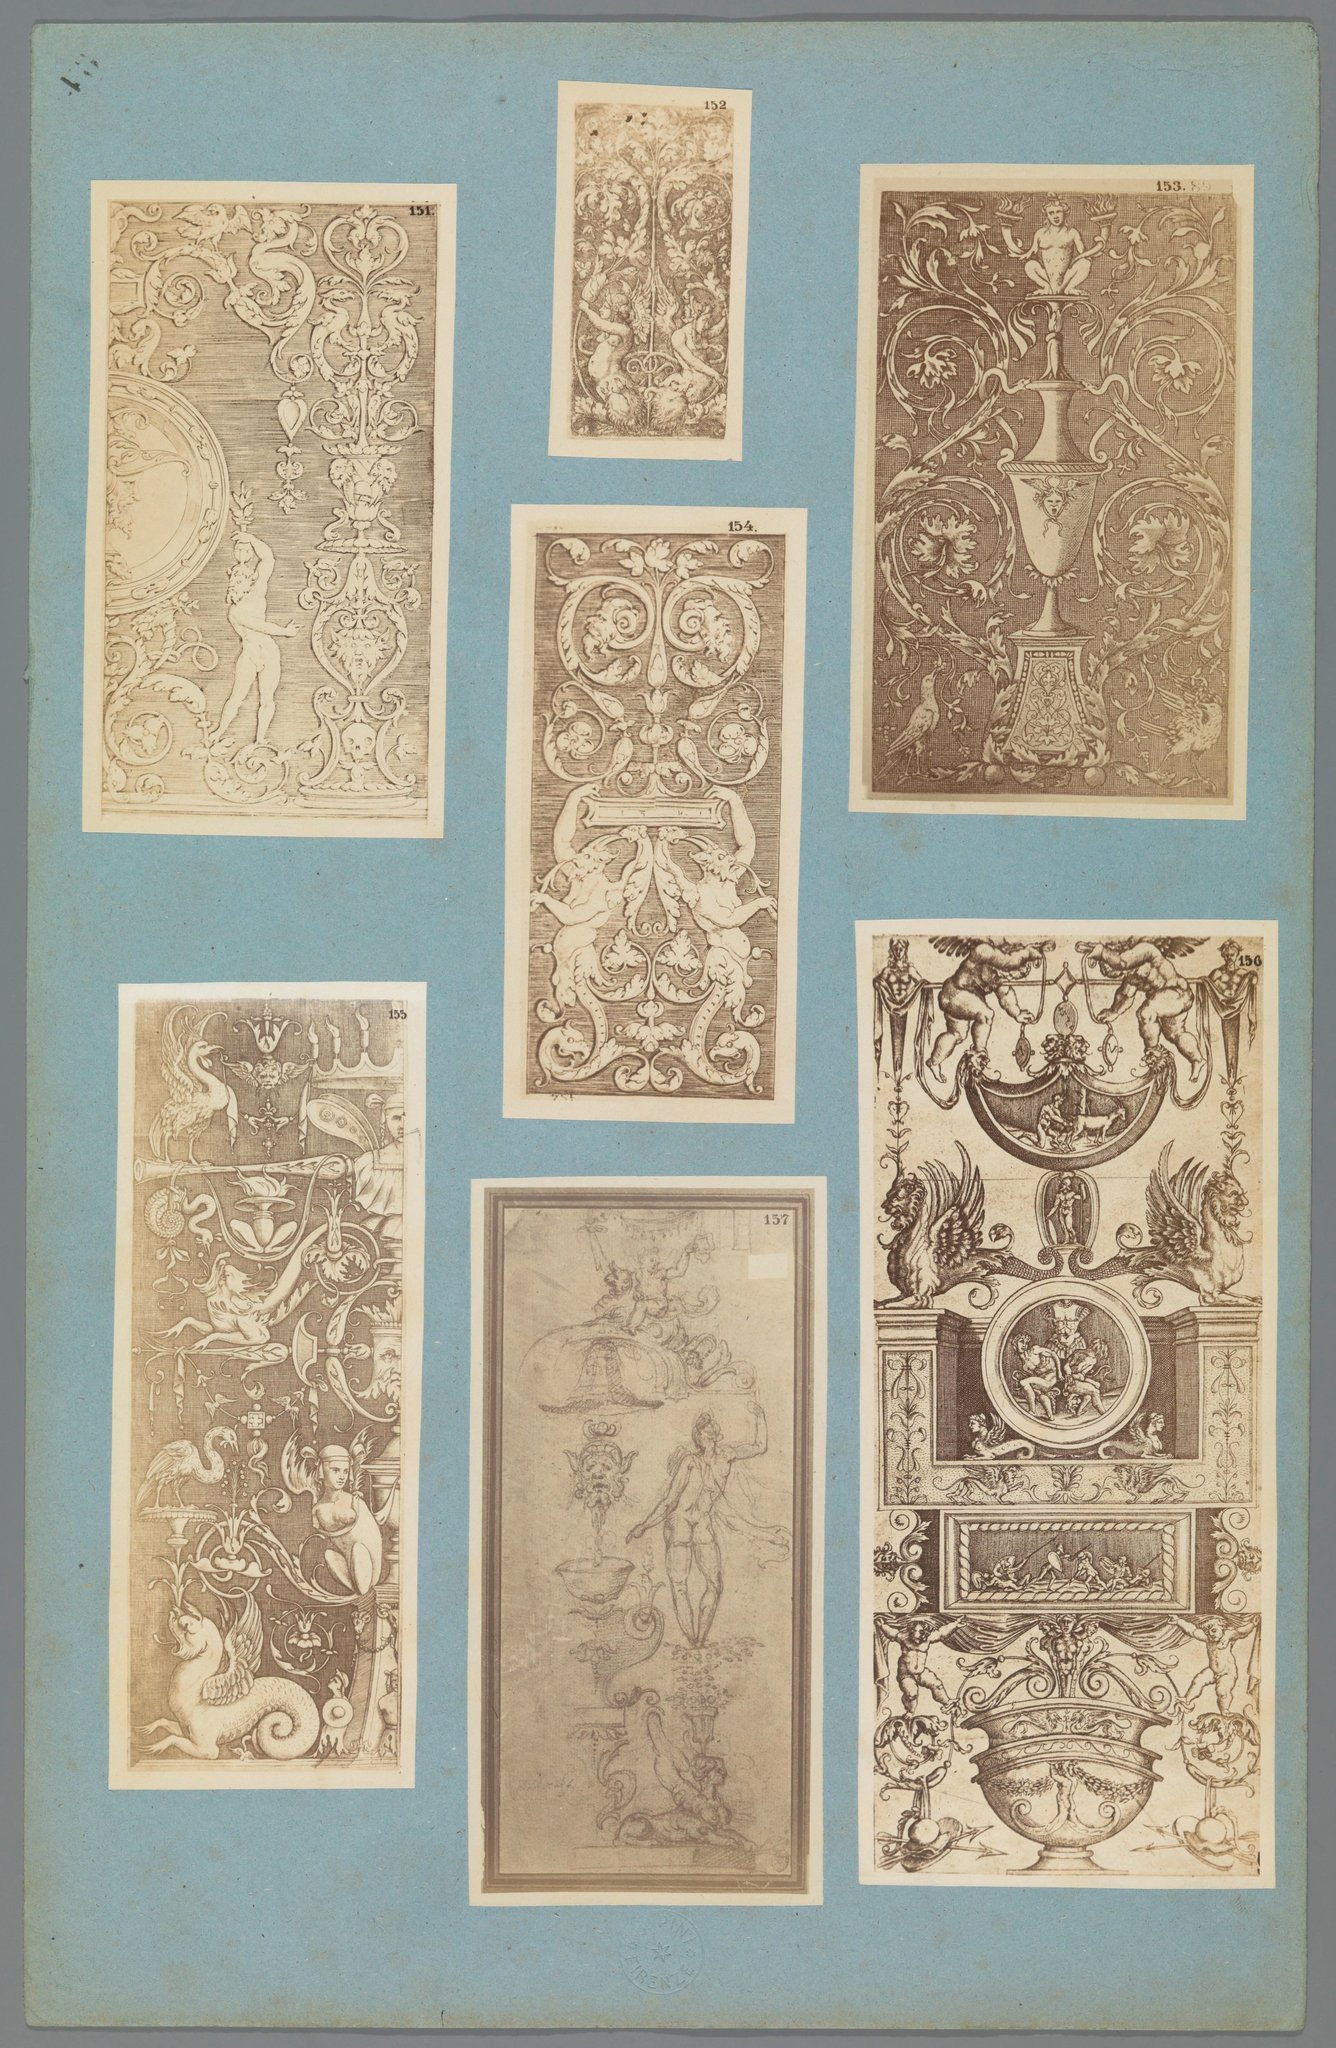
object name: reproduction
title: Zeven fotoreproducties van ornamentprenten en een ornamenttekening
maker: Anonymous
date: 1875-1900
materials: cardboard, photographic support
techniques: albumen print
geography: europe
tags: ornament ~ hybrid animals, ornament ~ arabesque, ornament ~ candelabrum, ornament derived from architectural details, europe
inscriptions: name: ‘C. PINI FIRENZE’, number: ‘48’, number: ‘152’, number: ‘154.’, number: ‘156’, number: ‘153.’, number: ‘155’, number: ‘151.’, number: ‘157’, collector's mark: Lugt 3937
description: Linksboven (151) een prent van een portret met decoratie, linksonder (155) een prent van fantasiewezens, middenboven (152) een prent van twee gehelmde vrouwenfiguren, midden (154) een prent van twee gehoornde fantasiewezens, middenonder (15) een tekening van een naakte figuur en een sfinx, rechtsboven (153) een prent van een kandelaber en arabesken, rechtsonder (156) een prent van een veldslag en fantasiewezens.